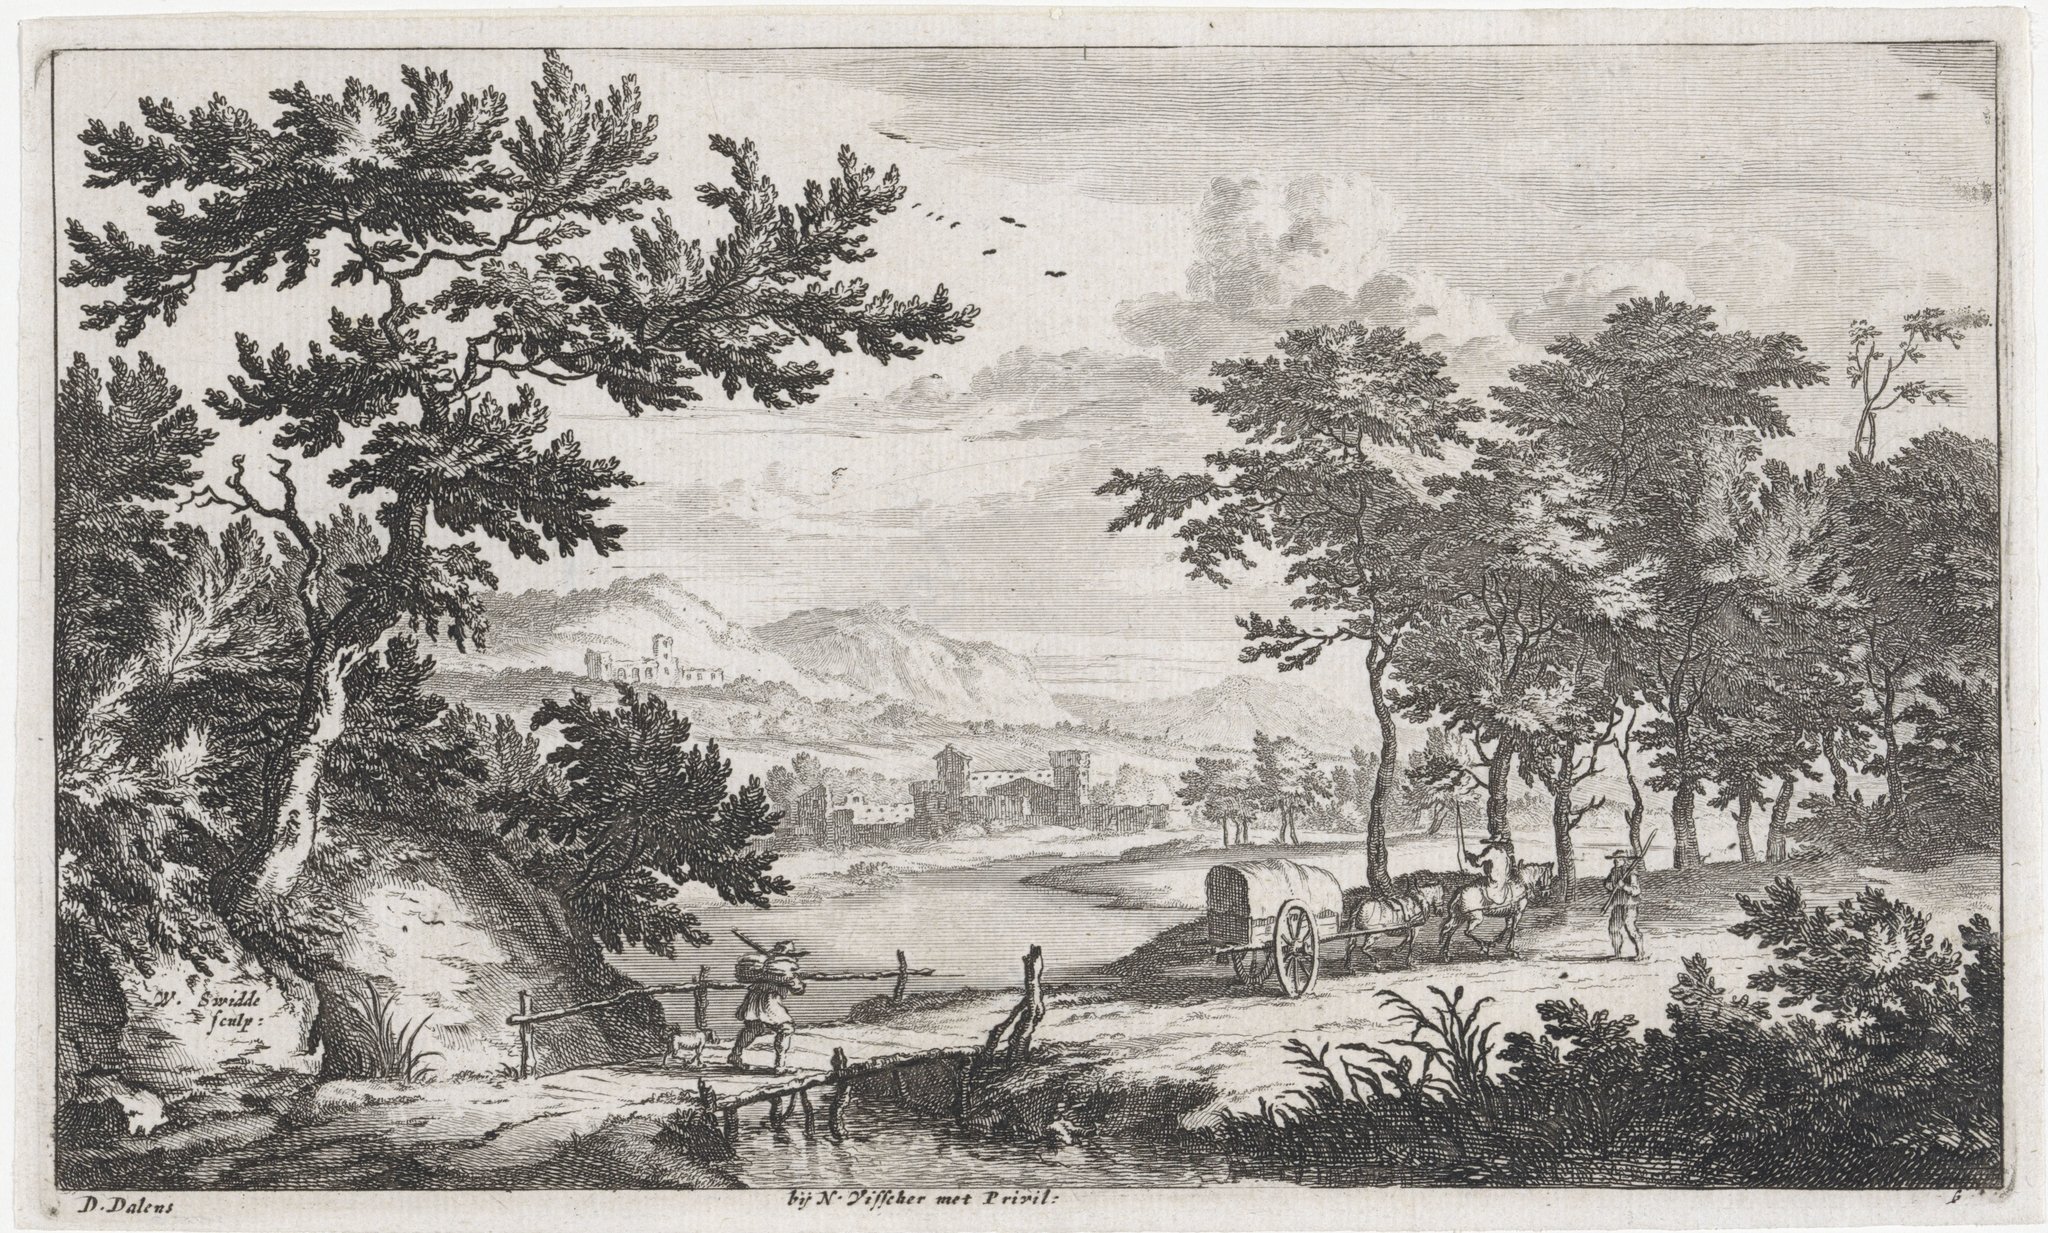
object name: print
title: Landschappen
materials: paper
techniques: etching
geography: amsterdam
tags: river - hh - ideal landscapes, abbey, monastery, convent ~ roman catholic church, covered wagon, hooded wagon, bridge, dog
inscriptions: collector's mark: Lugt 2228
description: Een man loopt met zijn hond over een lage houten brug over een rivier. Aan de oever ligt op de achtergrond een stad. Hoger in de heuvels ligt een abdij. Op de weg op de voorgrond rijdt een door twee paarden getrokken huifkar. Op het voorste paard zit een man met een zweep. Een man met een stok loopt de kar tegemoet.